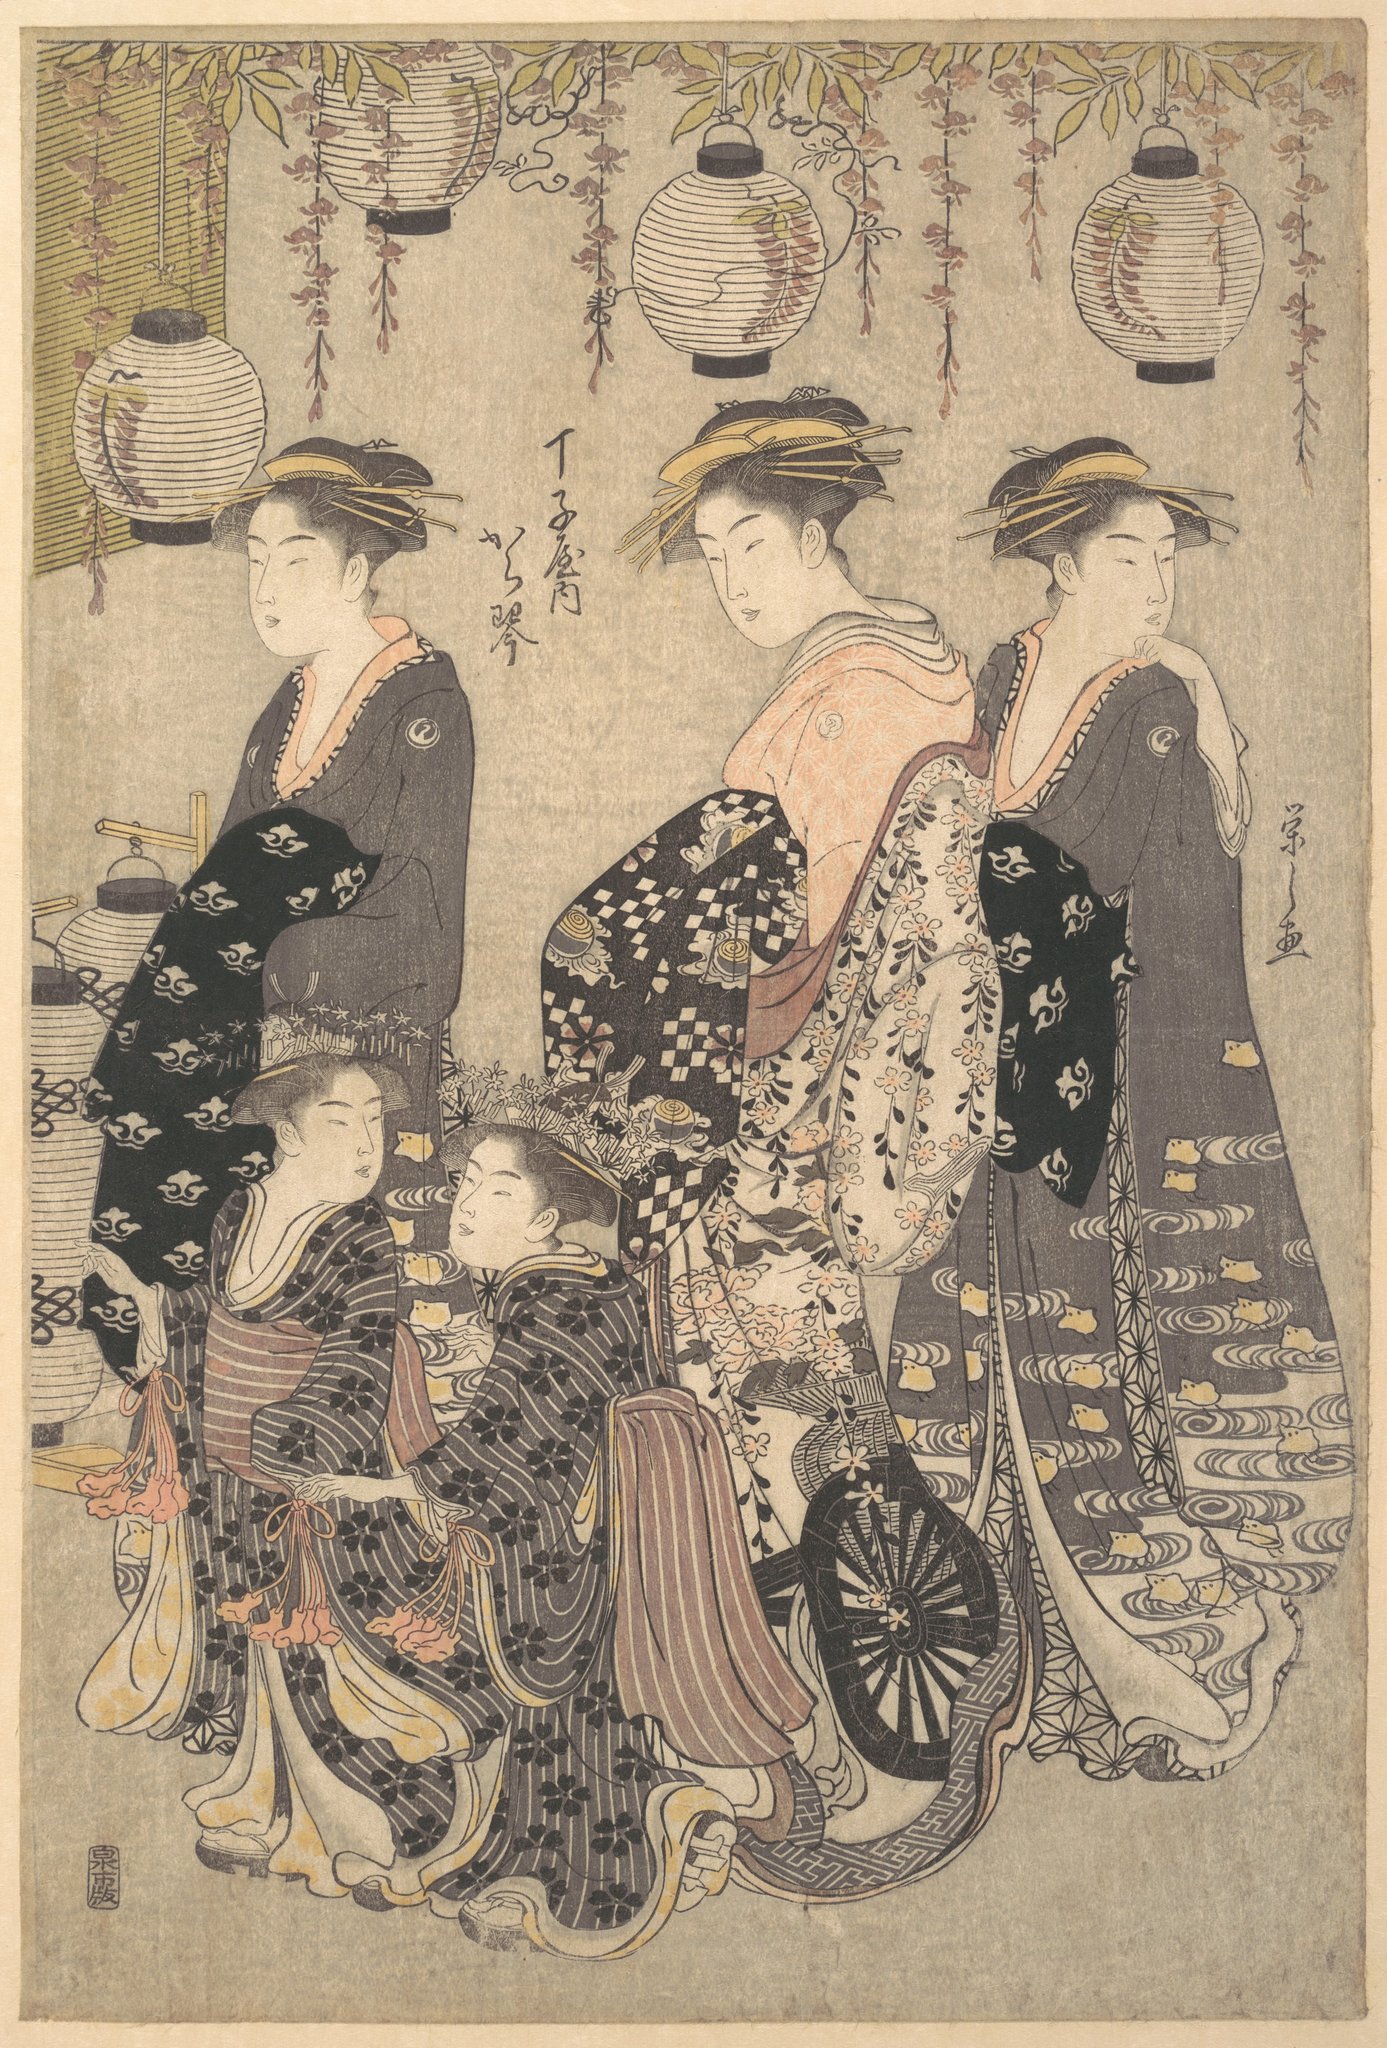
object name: print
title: Karakoto of Chojiya on Parade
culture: japanese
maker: chōbunsai eishi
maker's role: artist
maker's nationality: japanese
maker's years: 1756-1829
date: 1790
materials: ink, paper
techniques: woodblock print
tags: girls,women